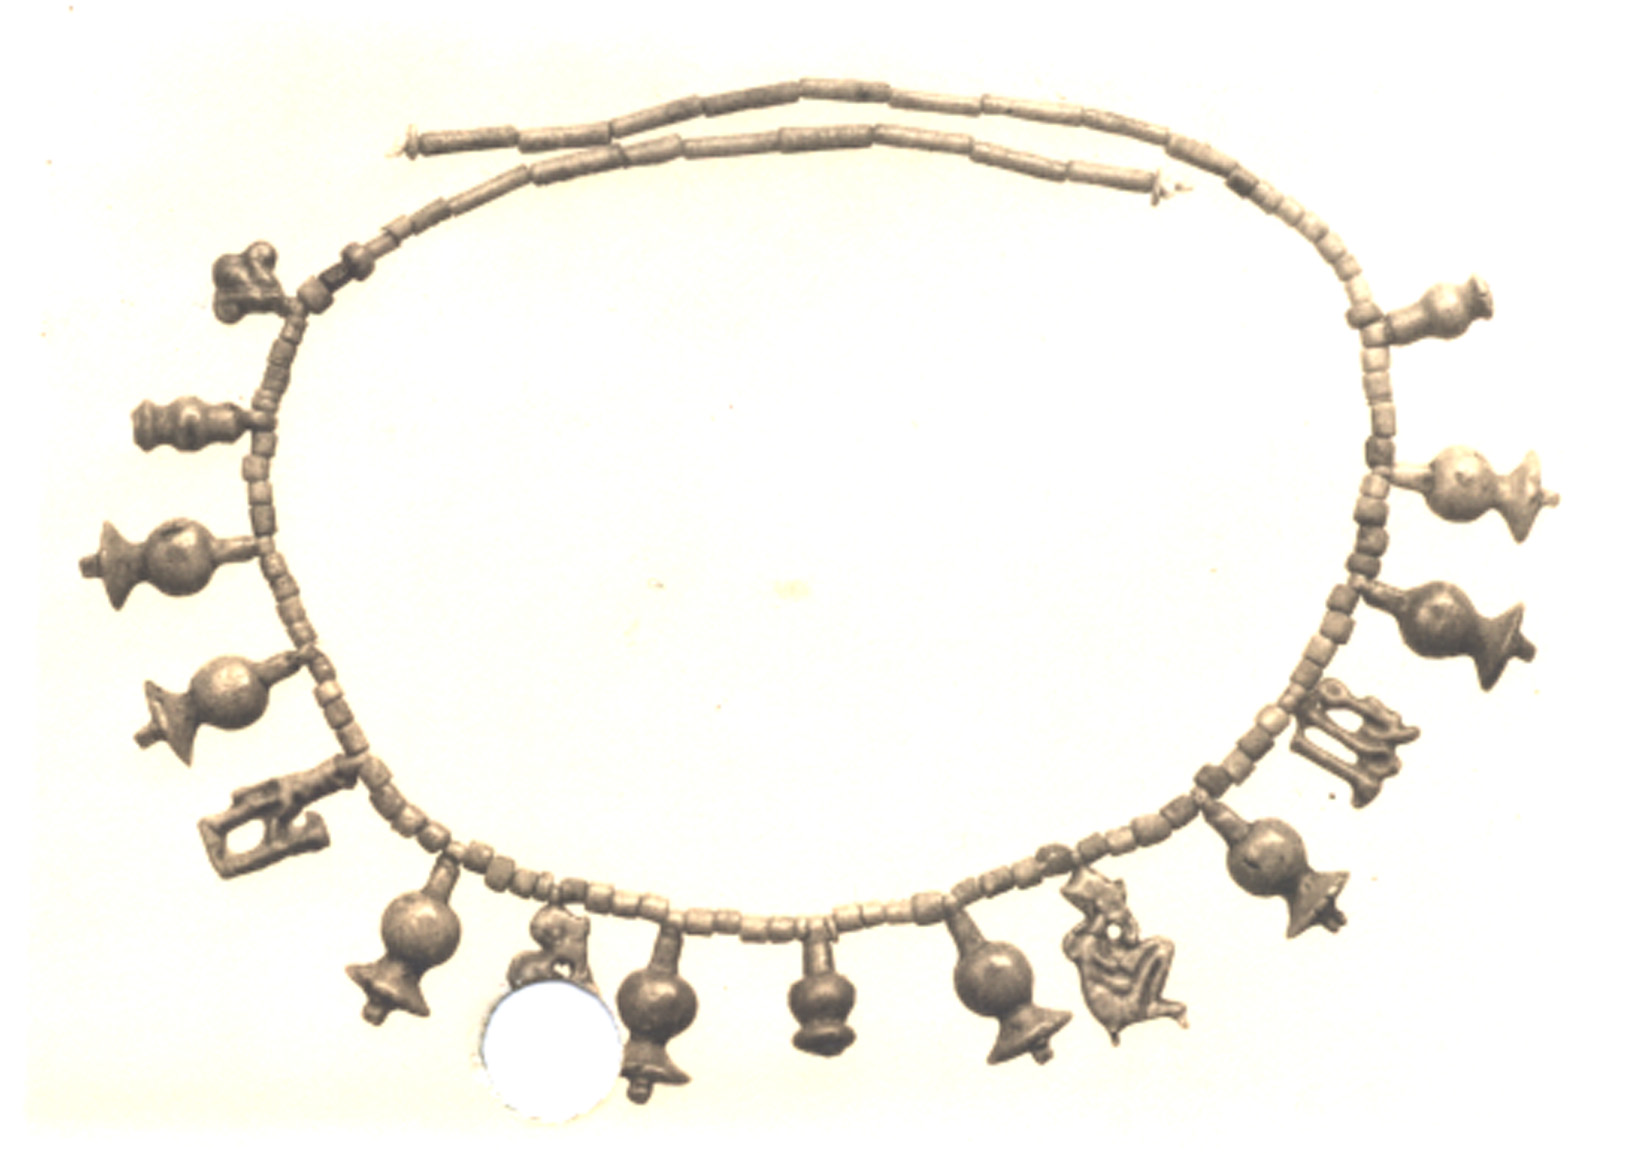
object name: necklace, bead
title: String of beads and amulets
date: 1353-1323 BCE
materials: faience, glass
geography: egypt